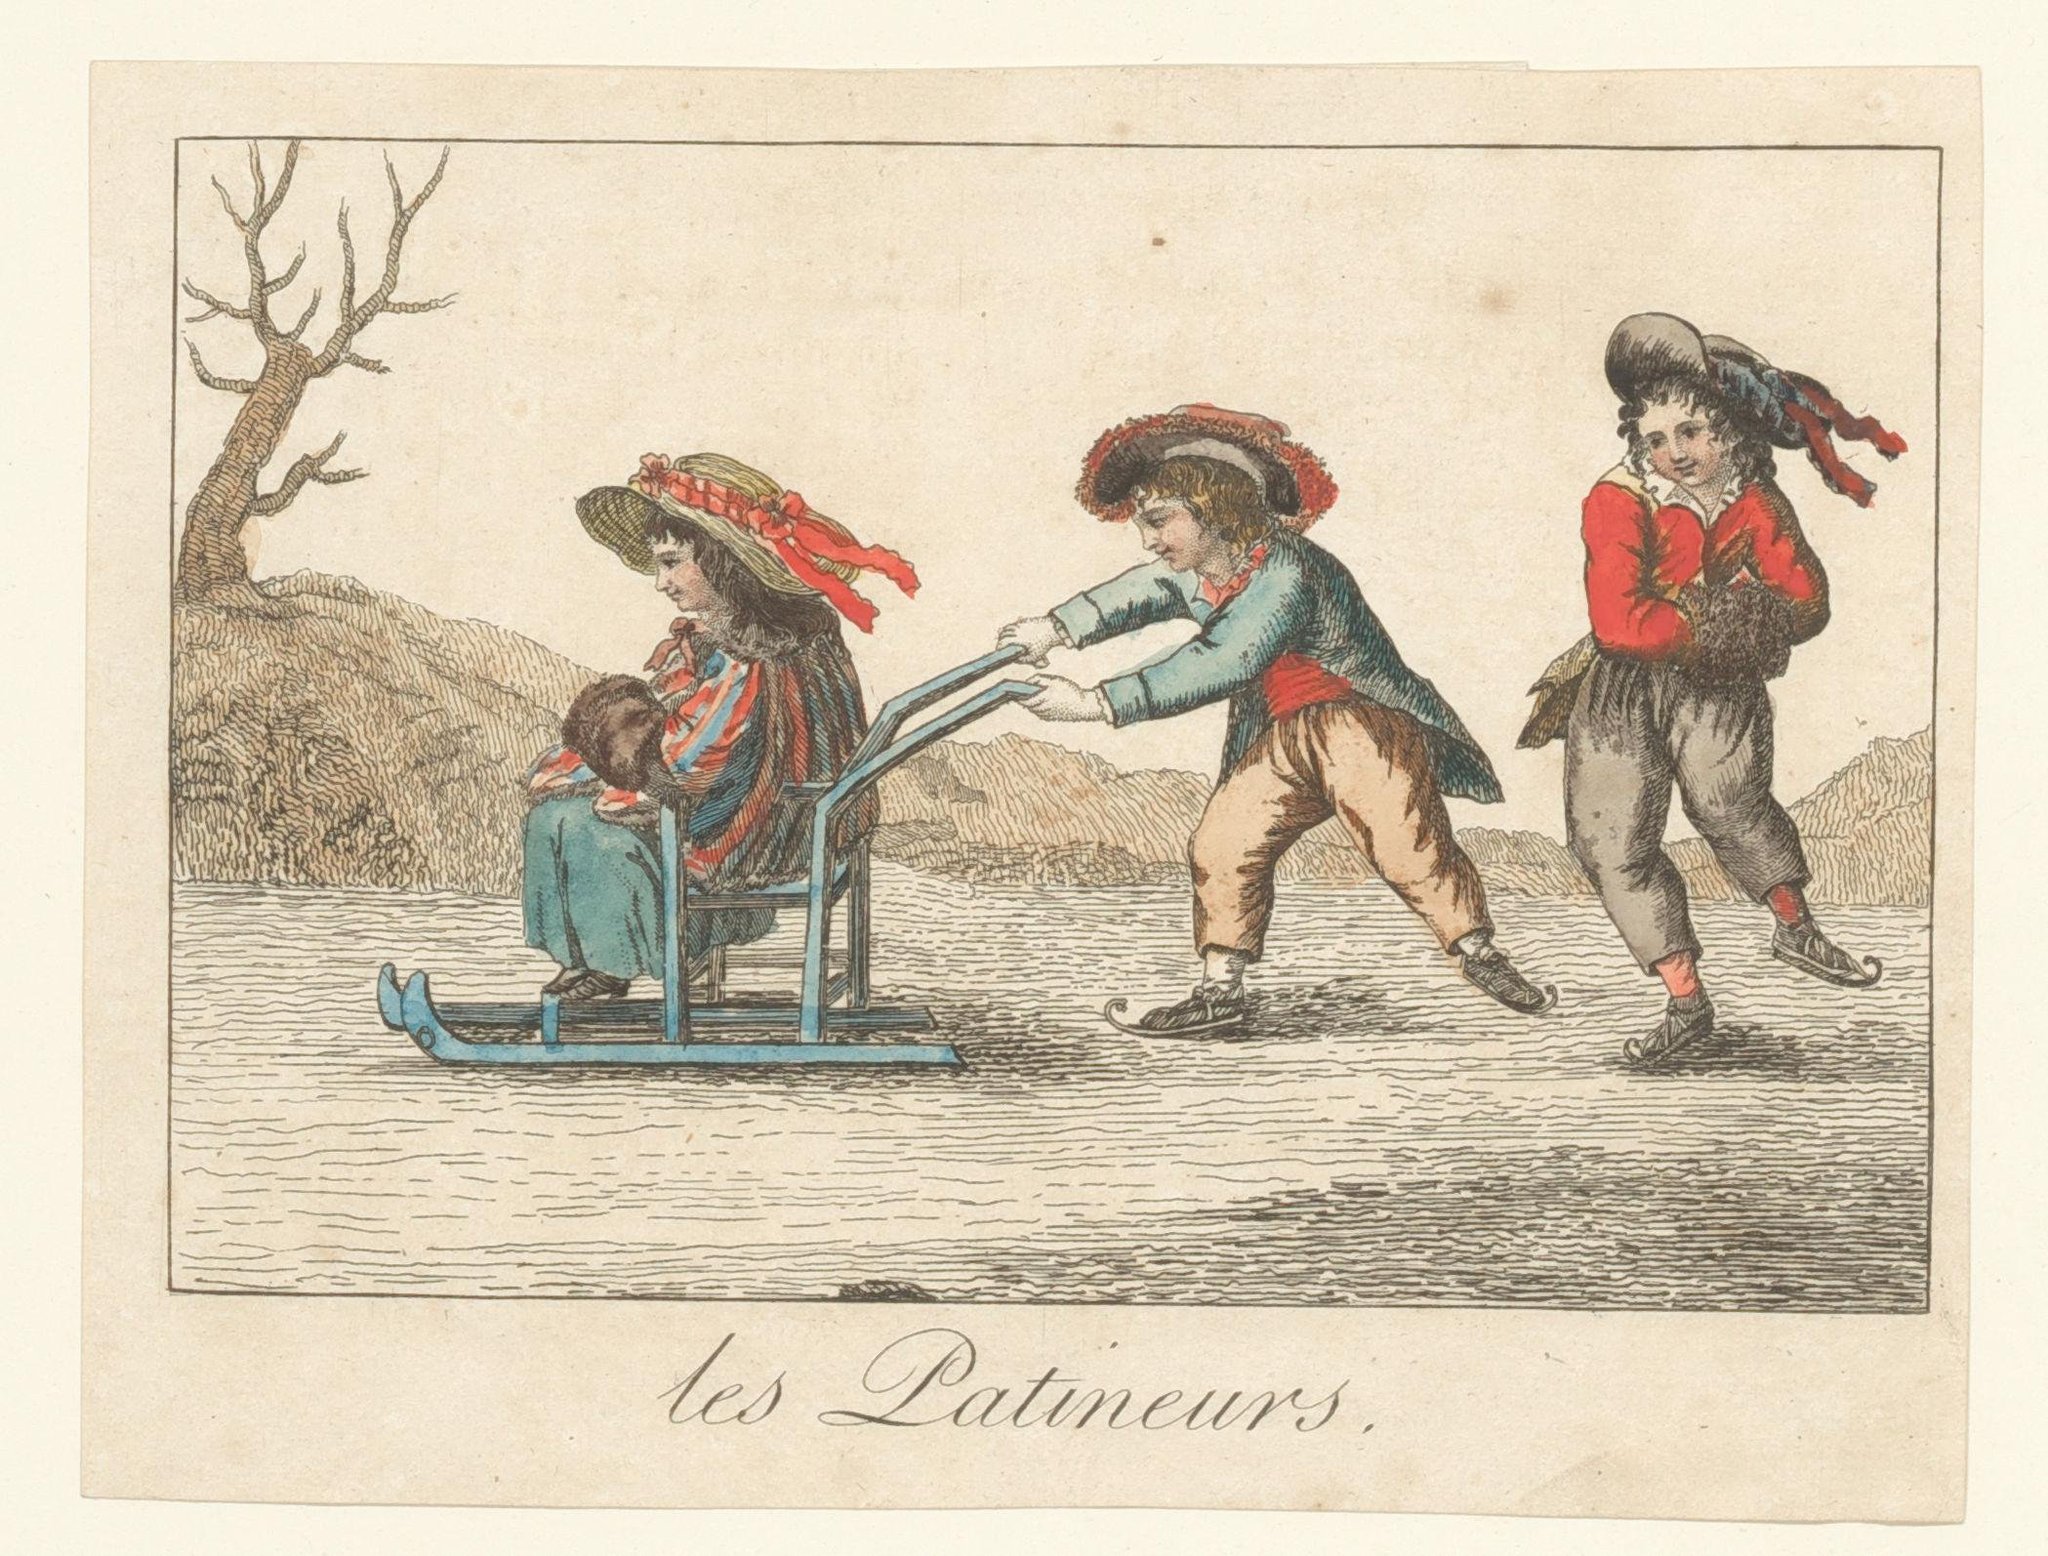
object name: print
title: Schaatsende en sleeënde kinderen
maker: Anonymous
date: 1800-1899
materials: paper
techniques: etching, hand coloring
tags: children's games and plays, throwing games, skates (winter sports)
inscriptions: collector's mark: Lugt 1641, stamp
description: Onderwerpsrubrieken binnen de Atlas Zeden en Gewoonten: Zeden en Gewoonten in Engeren Zin, Des menschen beging, midden en einde, Kinderleven – Kinderspel en Kinderprenten.